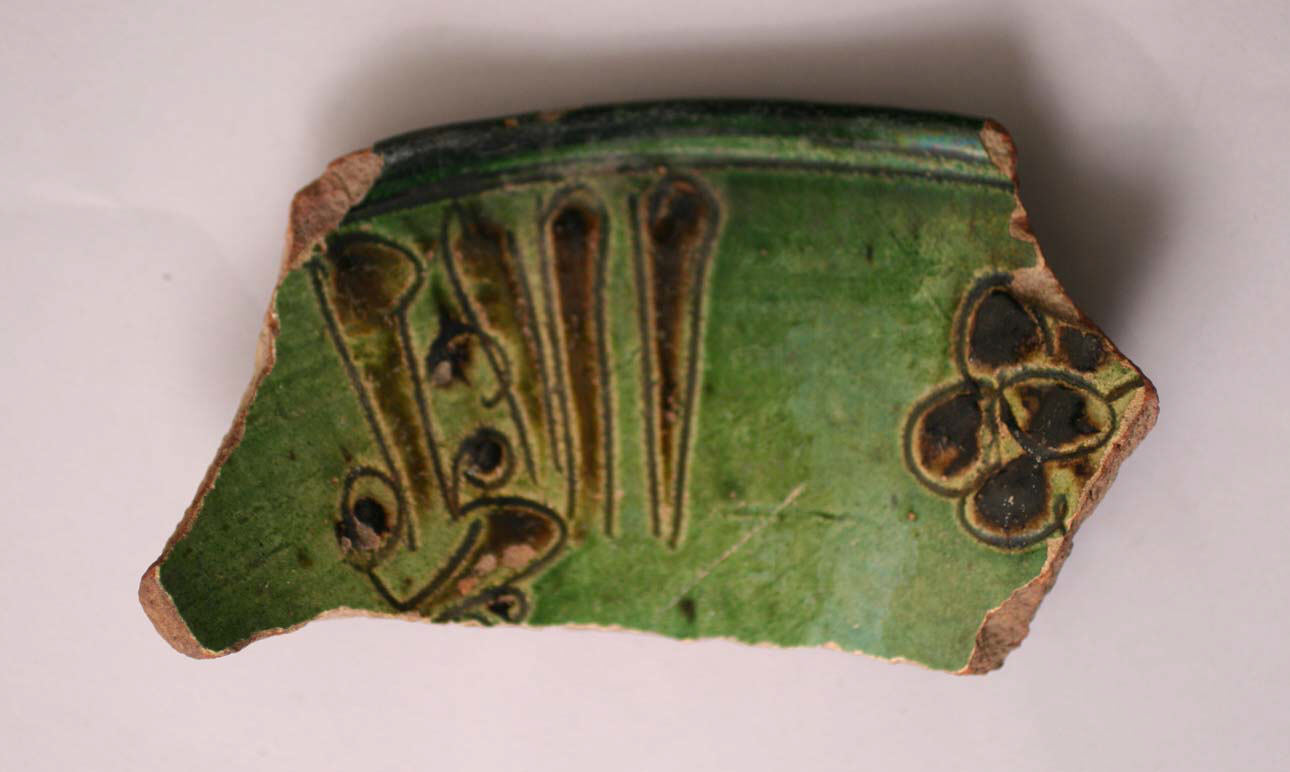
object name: fragment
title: Ceramic Fragment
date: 1301-1500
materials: earthenware, glaze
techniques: coloring, incising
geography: egypt